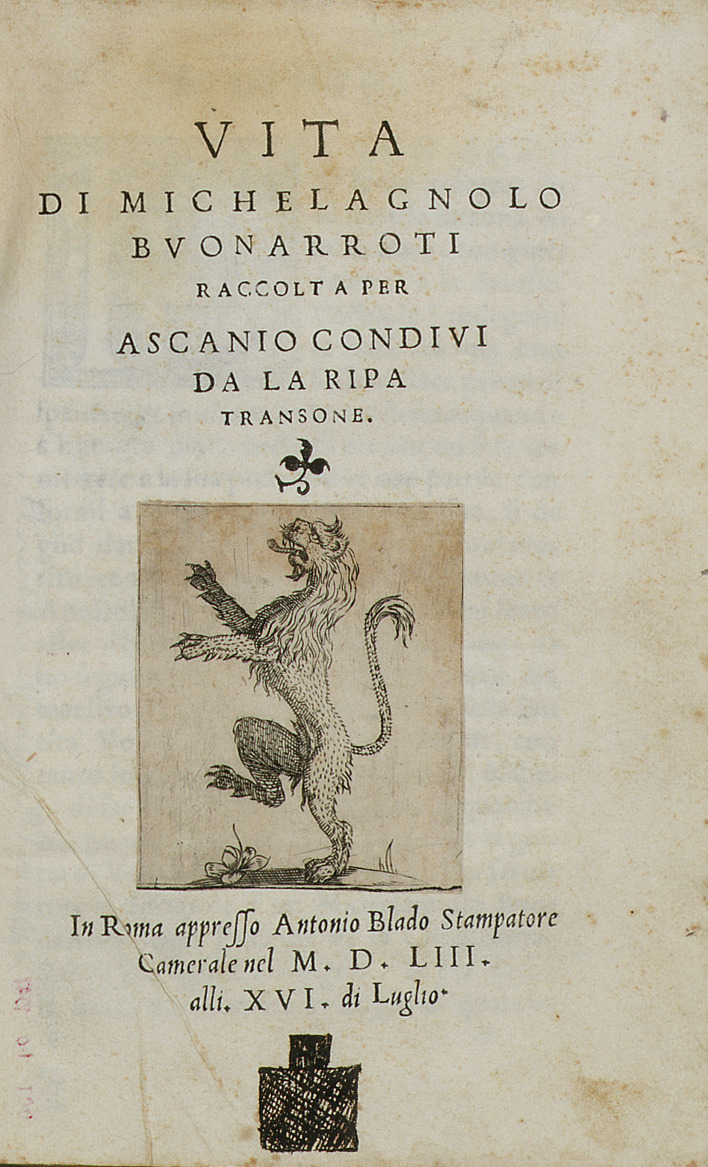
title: Vita di Michelagnolo Buonarroti raccolta per Ascanio Condivi da la Ripa Transone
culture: roman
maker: ascanio condivi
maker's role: author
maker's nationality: italian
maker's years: 1525-1574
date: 1553